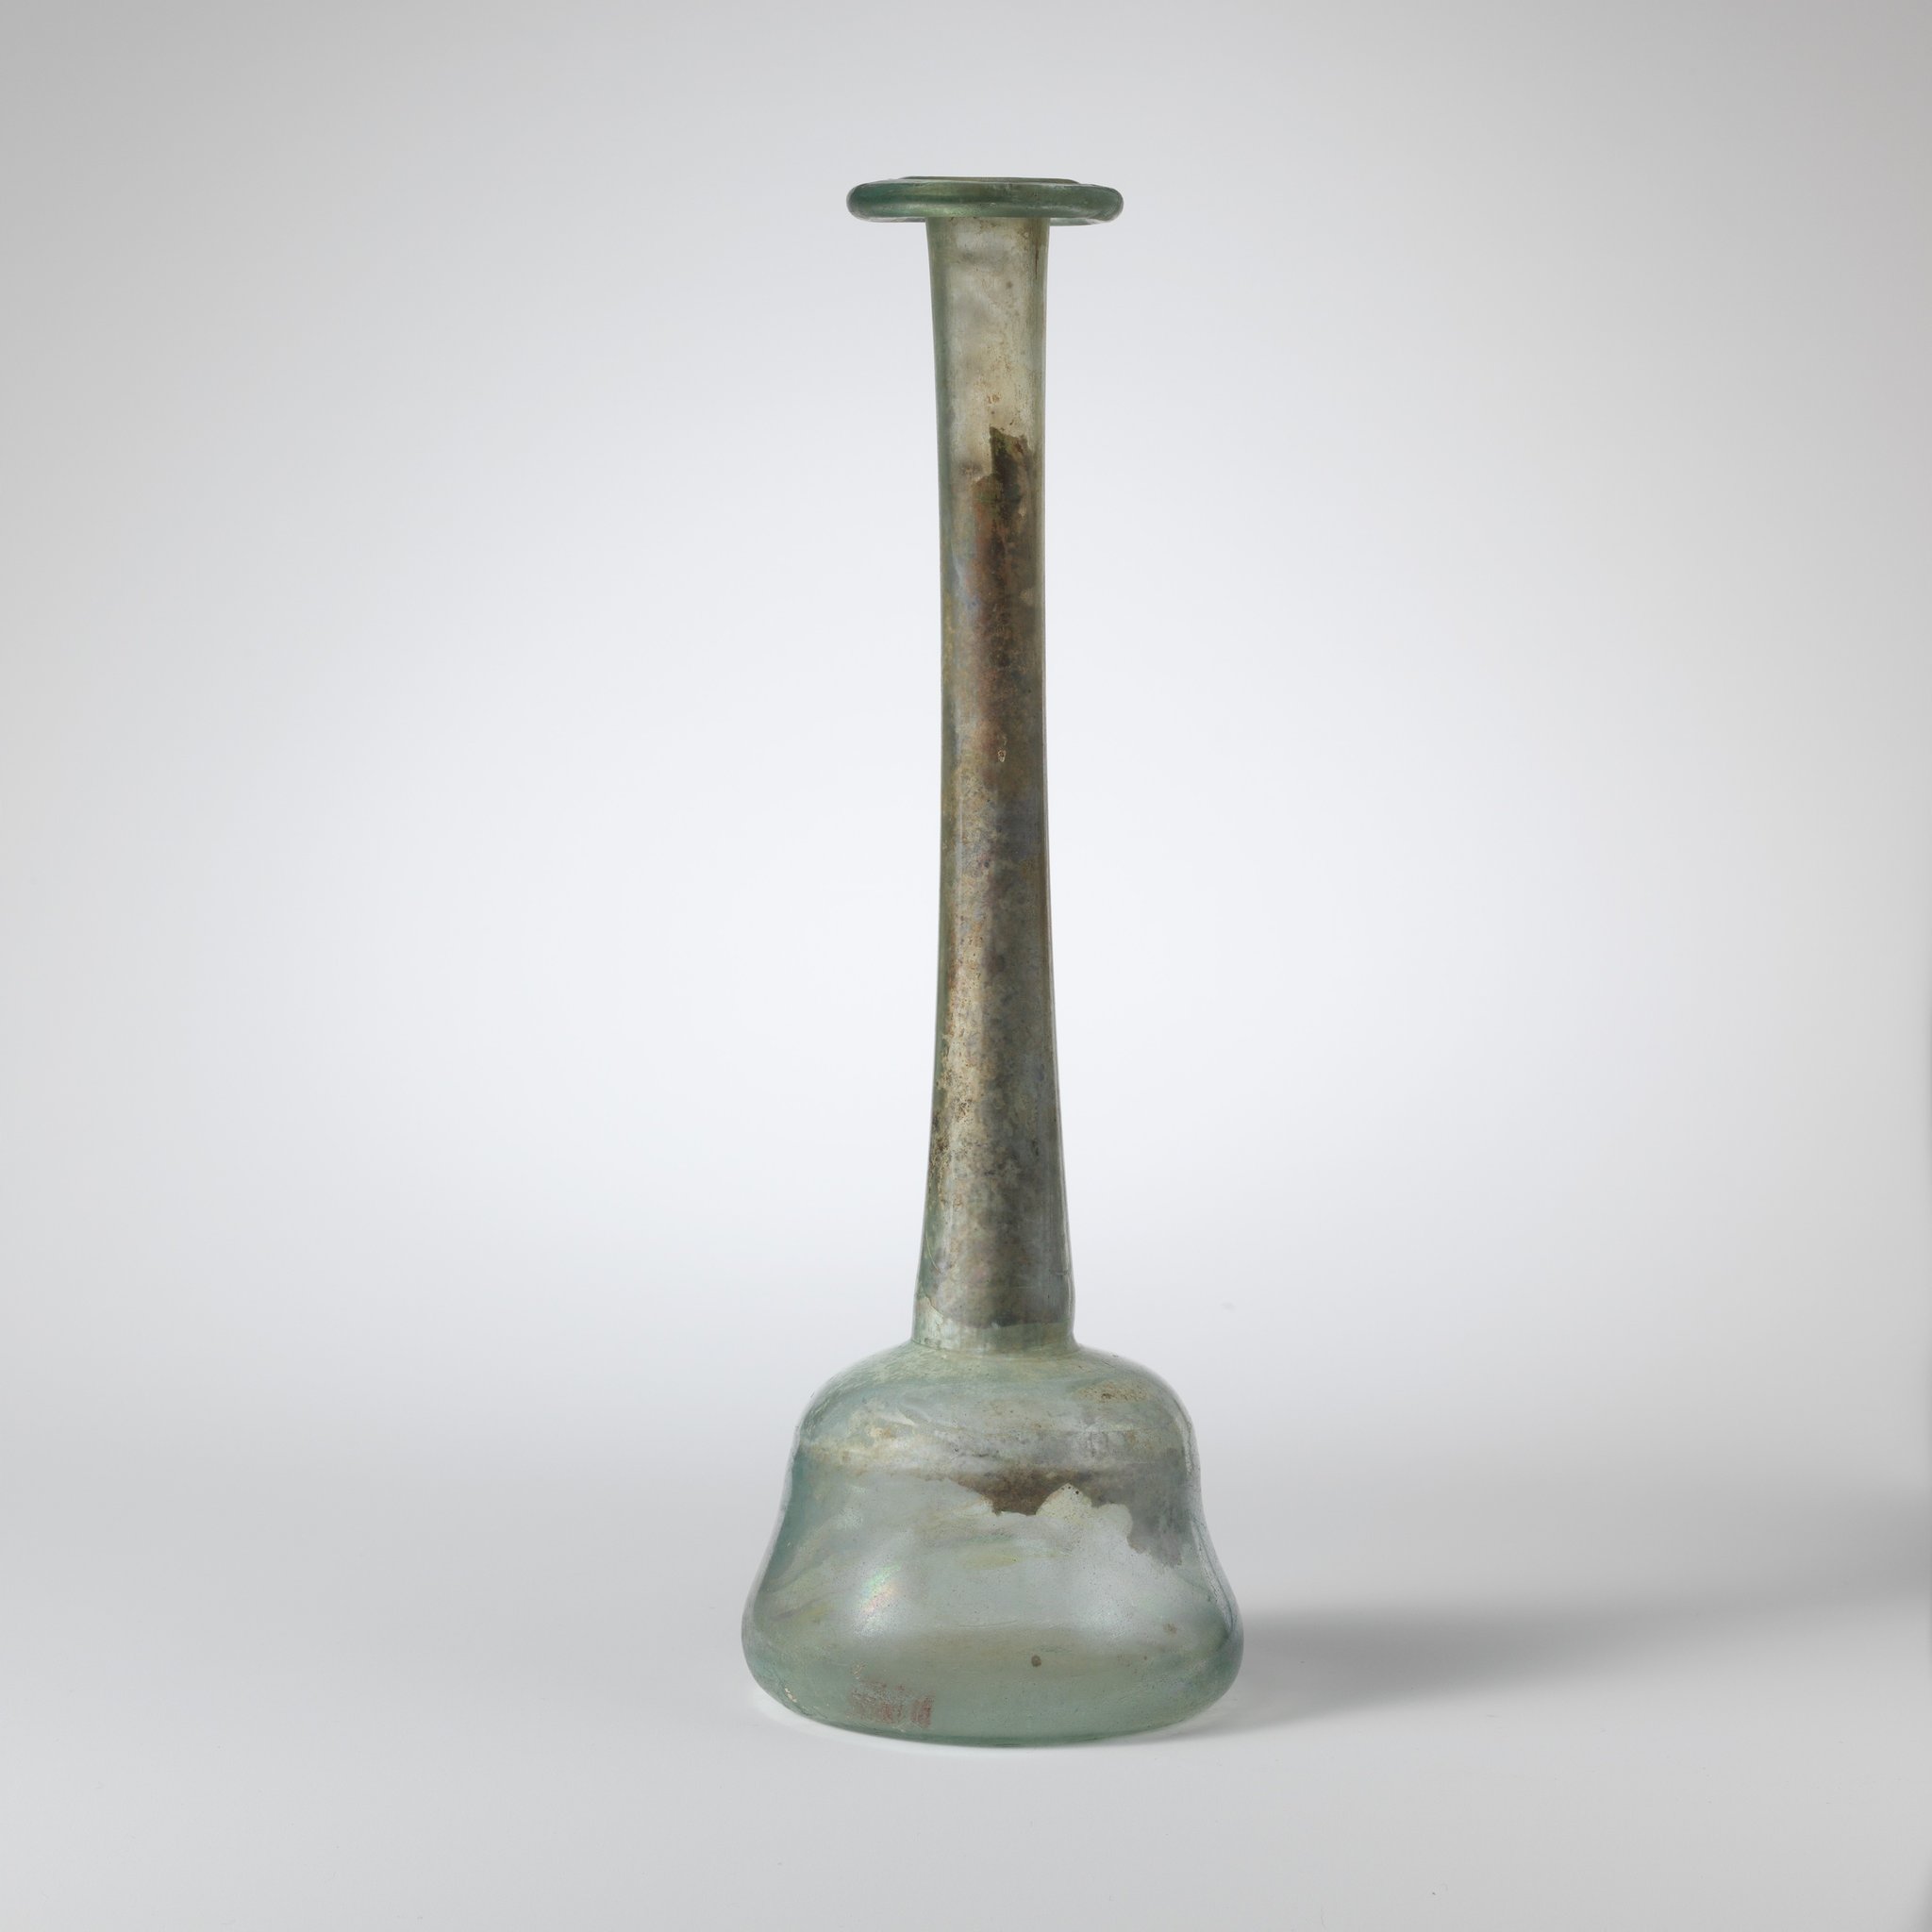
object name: perfume bottle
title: Glass perfume bottle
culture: roman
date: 101-300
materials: glass